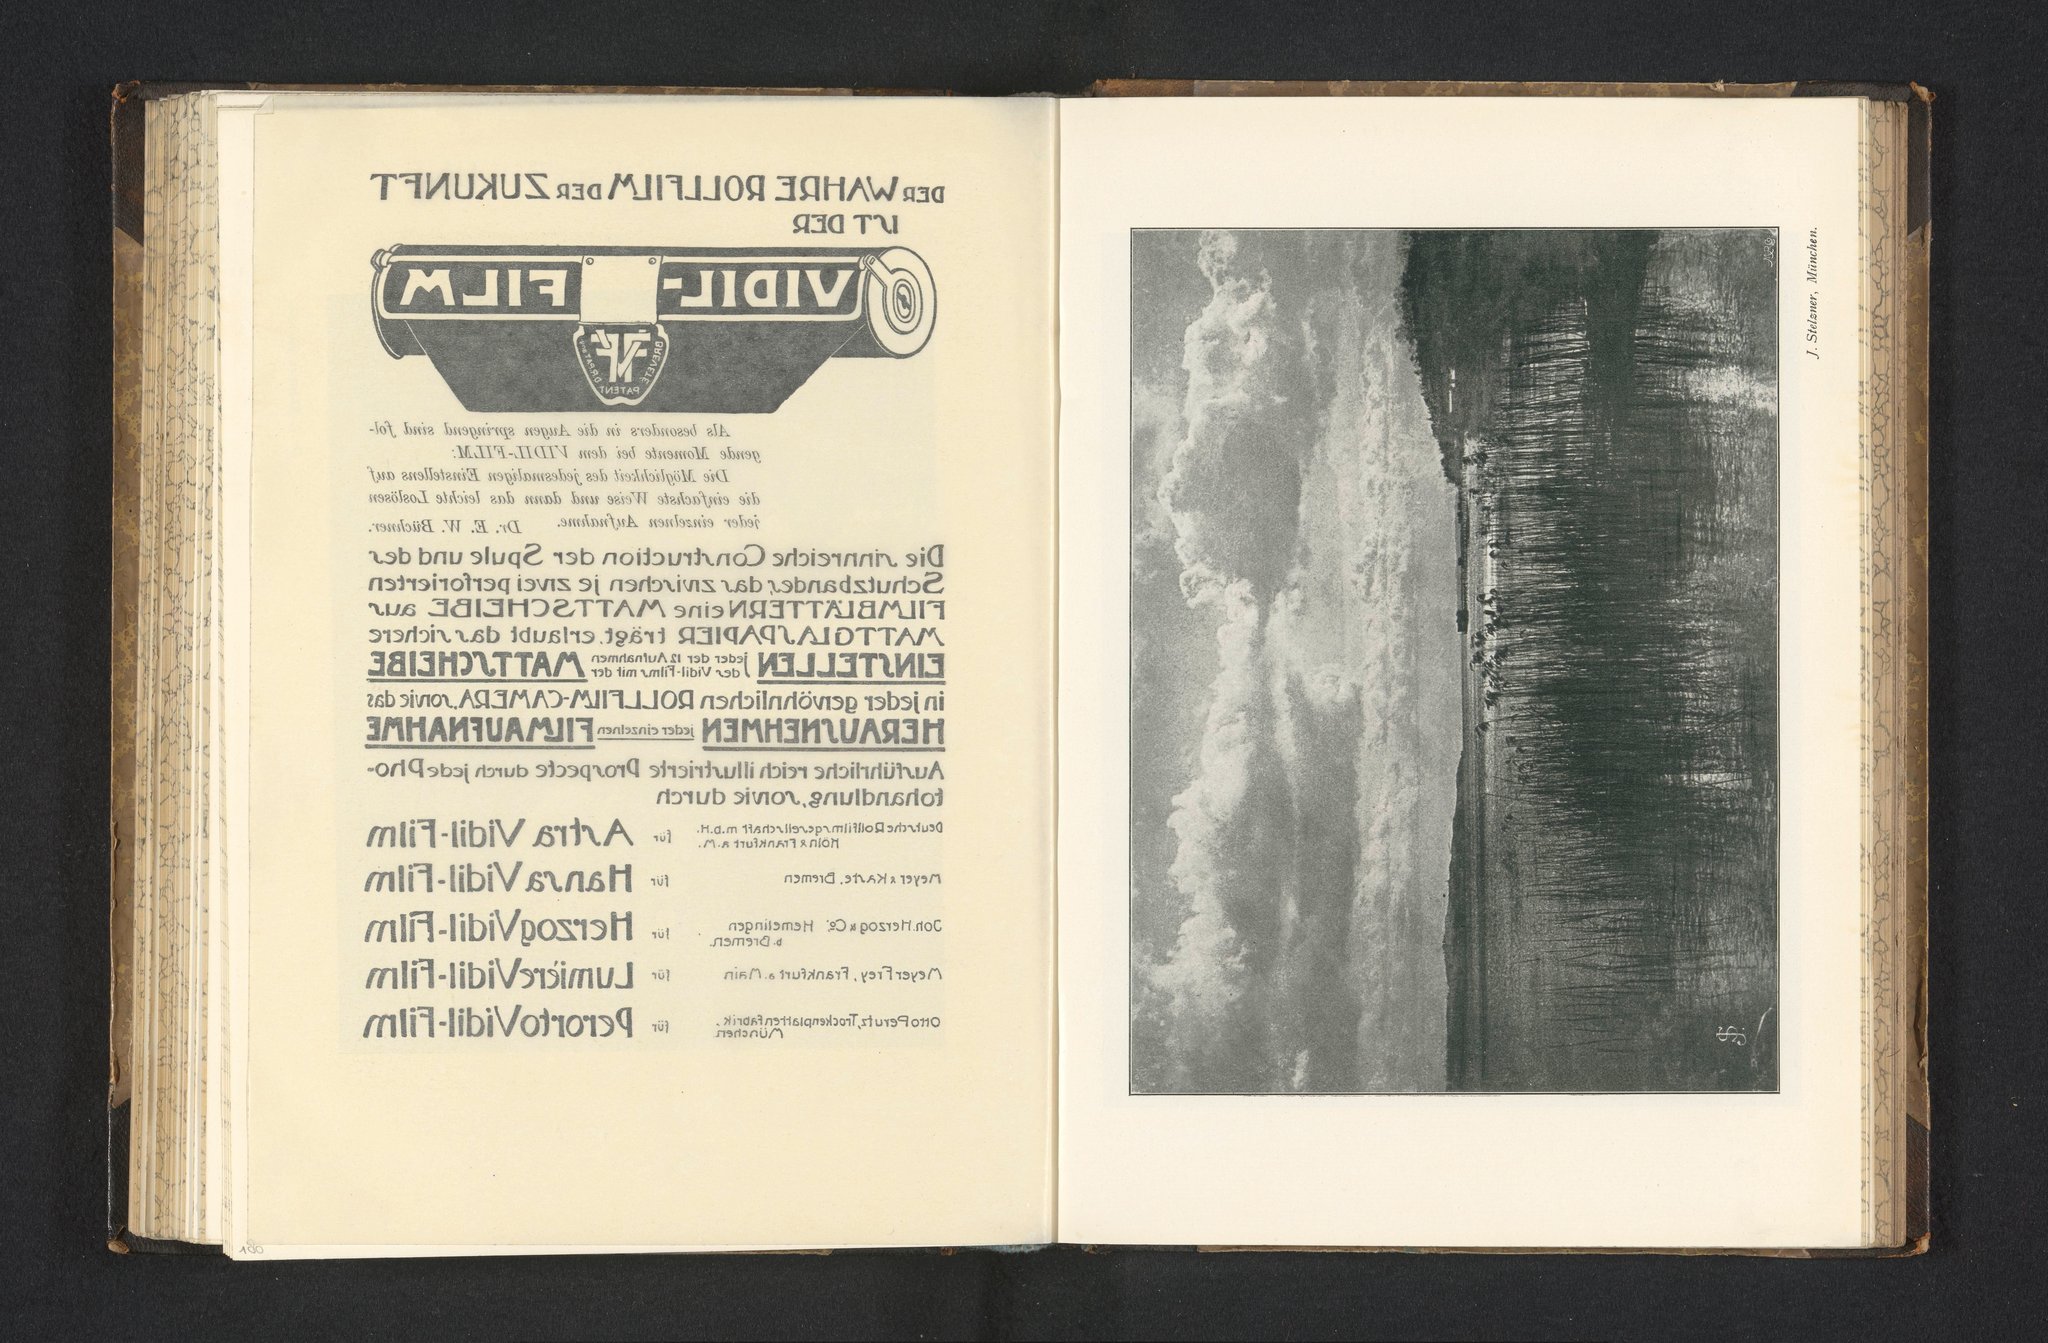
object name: photomechanical print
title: Landschap, met op de voorgrond een rietkraag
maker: j. stelzner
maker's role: fotograaf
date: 1898-1903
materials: paper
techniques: autotype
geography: berlin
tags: landscapes, plants and herbs: reed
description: Prent op derde ongenummerde pagina na pagina 290, achter semi-transparante omslag met reclameboodschap.